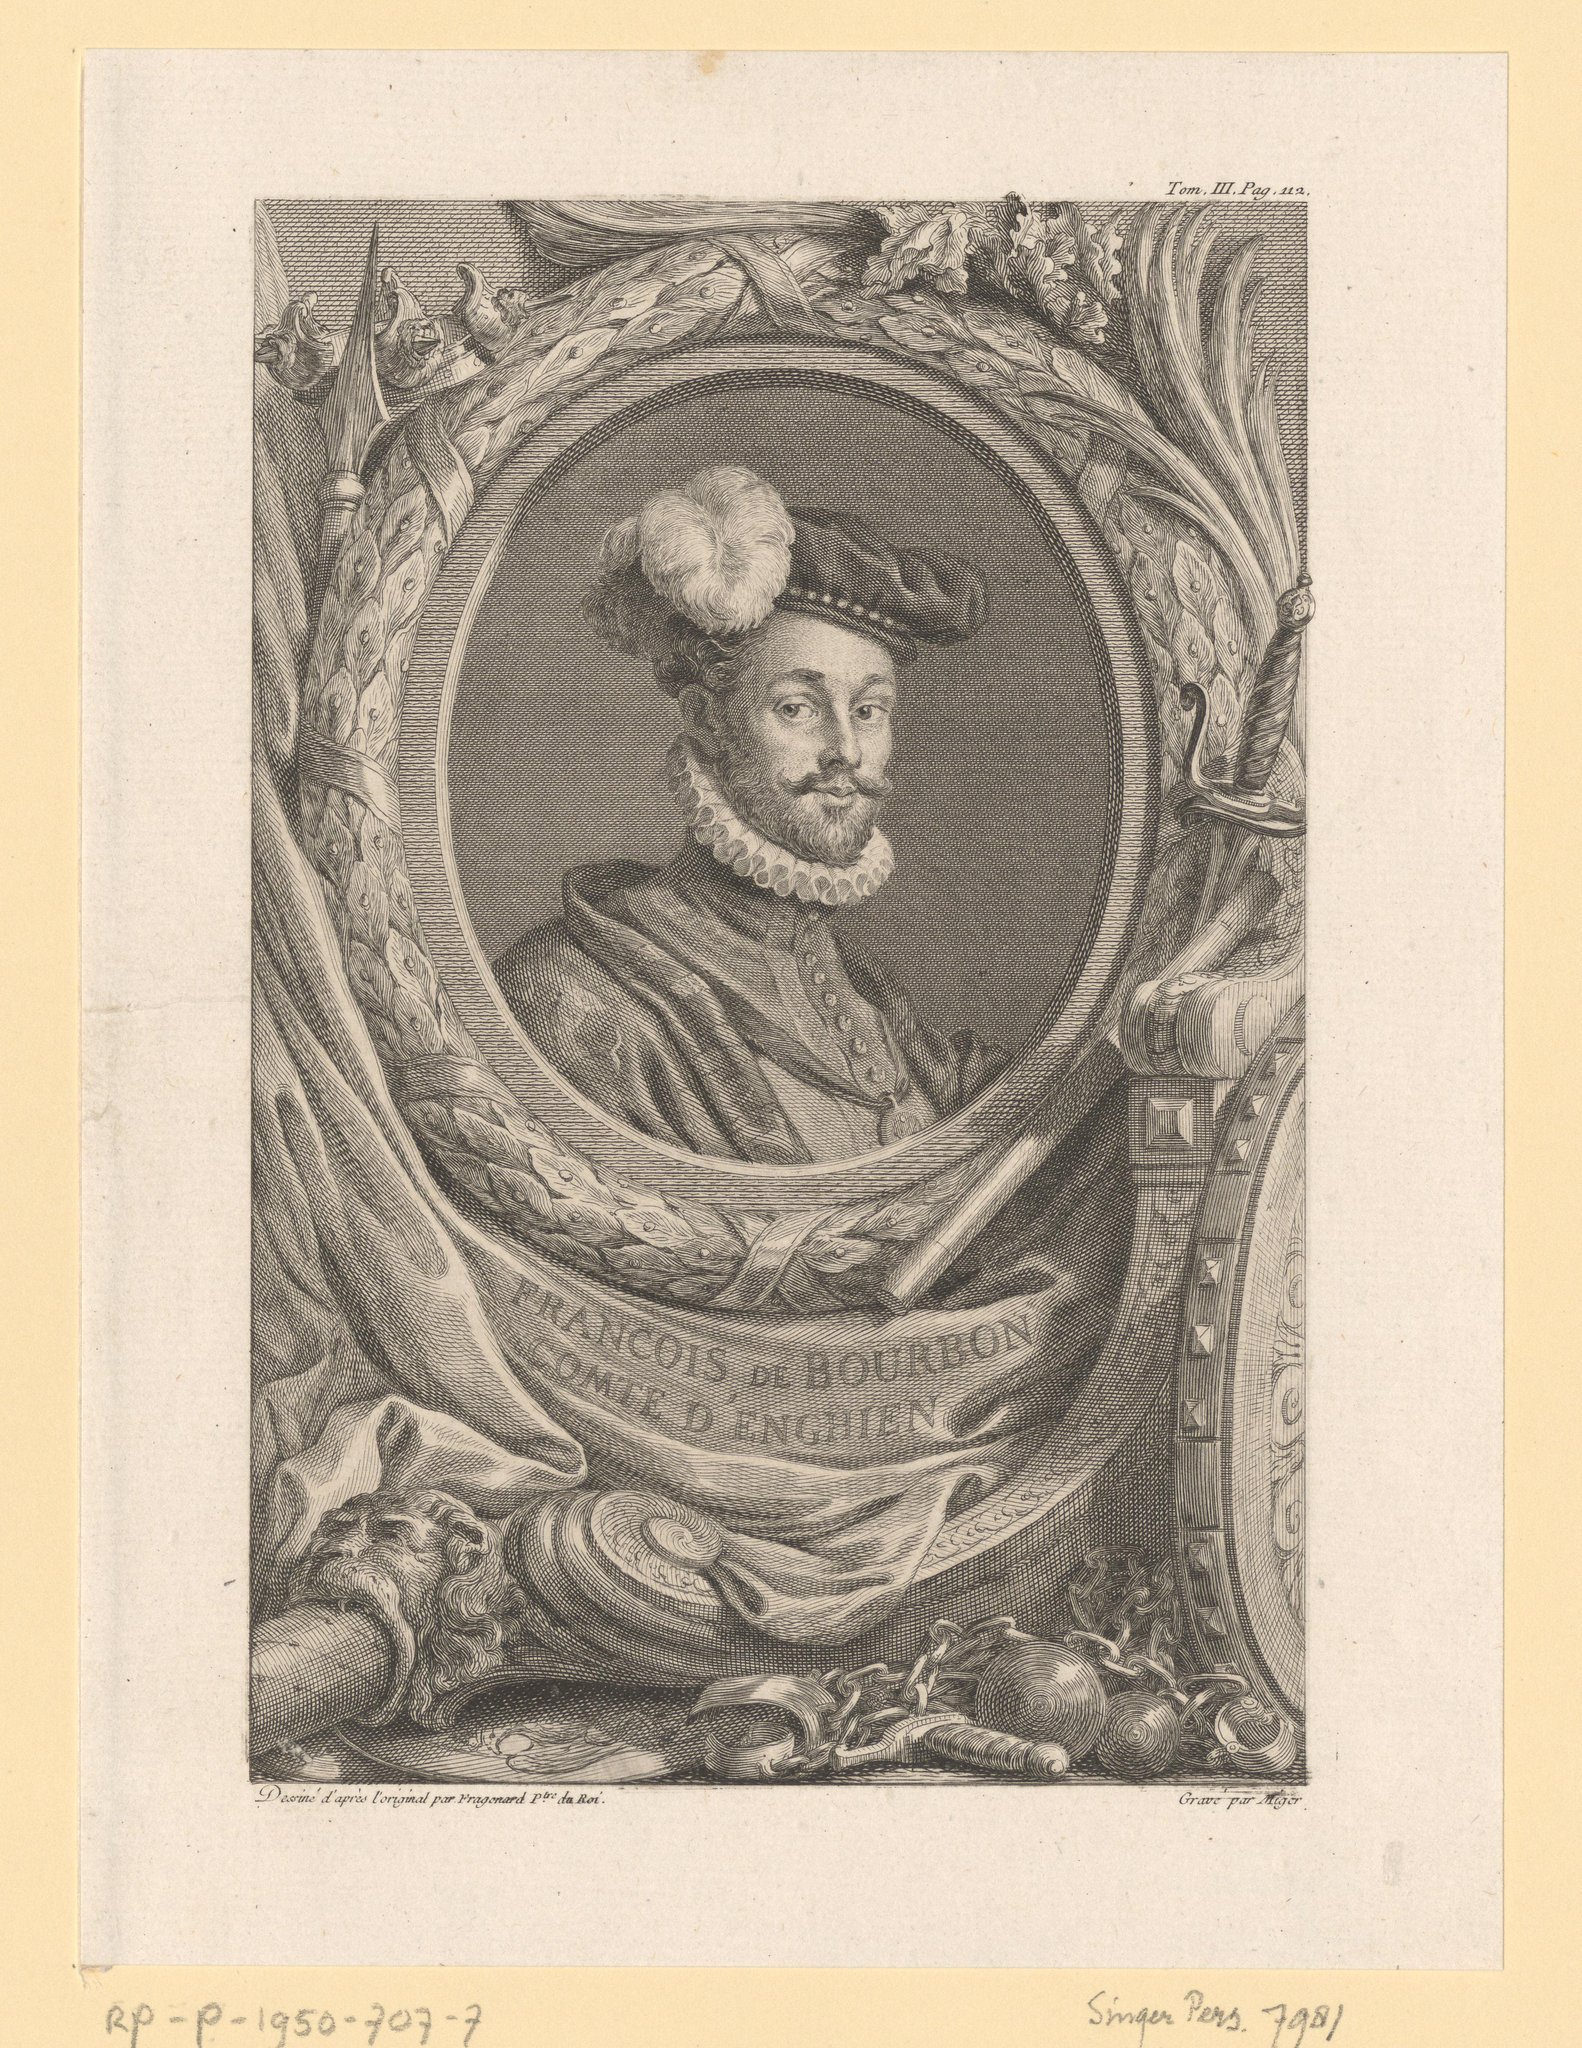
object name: print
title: Portret van Frans van Bourbon-Condé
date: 1782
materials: paper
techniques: engraving, etching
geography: paris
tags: historical persons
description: Prent uit: Desormeaux, Joseph-Louis-Ripault. Histoire de la Maison de Bourbon. Parijs: Imprimerie Royale, 1782, dl. 3.